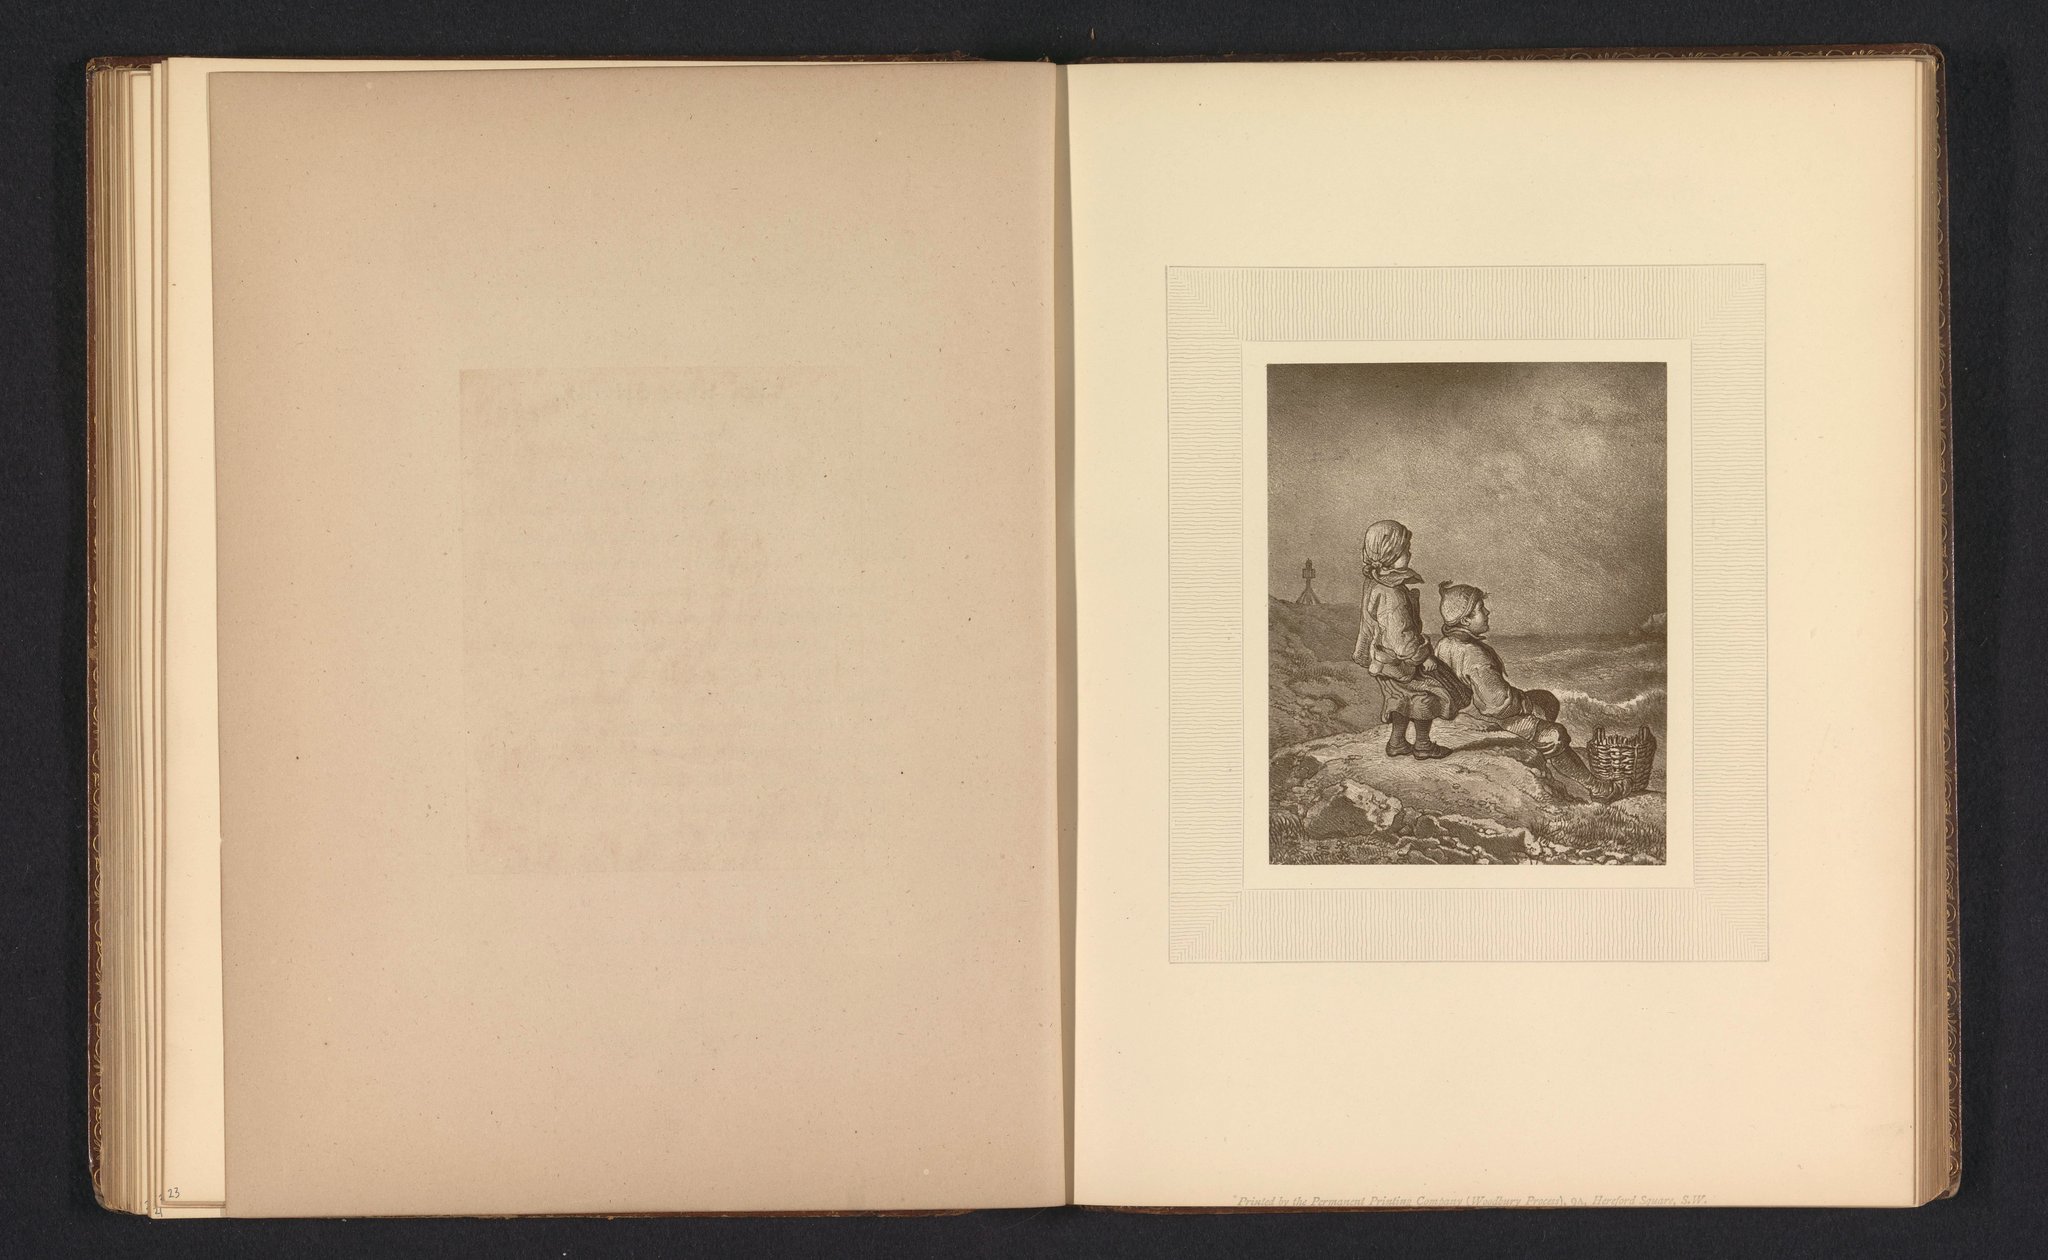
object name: page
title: Fotoreproductie van een prent naar een schilderij met kinderen op een rotskust door Adolph Tidemand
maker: Anonymous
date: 1864-1874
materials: paper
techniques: woodburytype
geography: london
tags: rocky coast, picture, painting